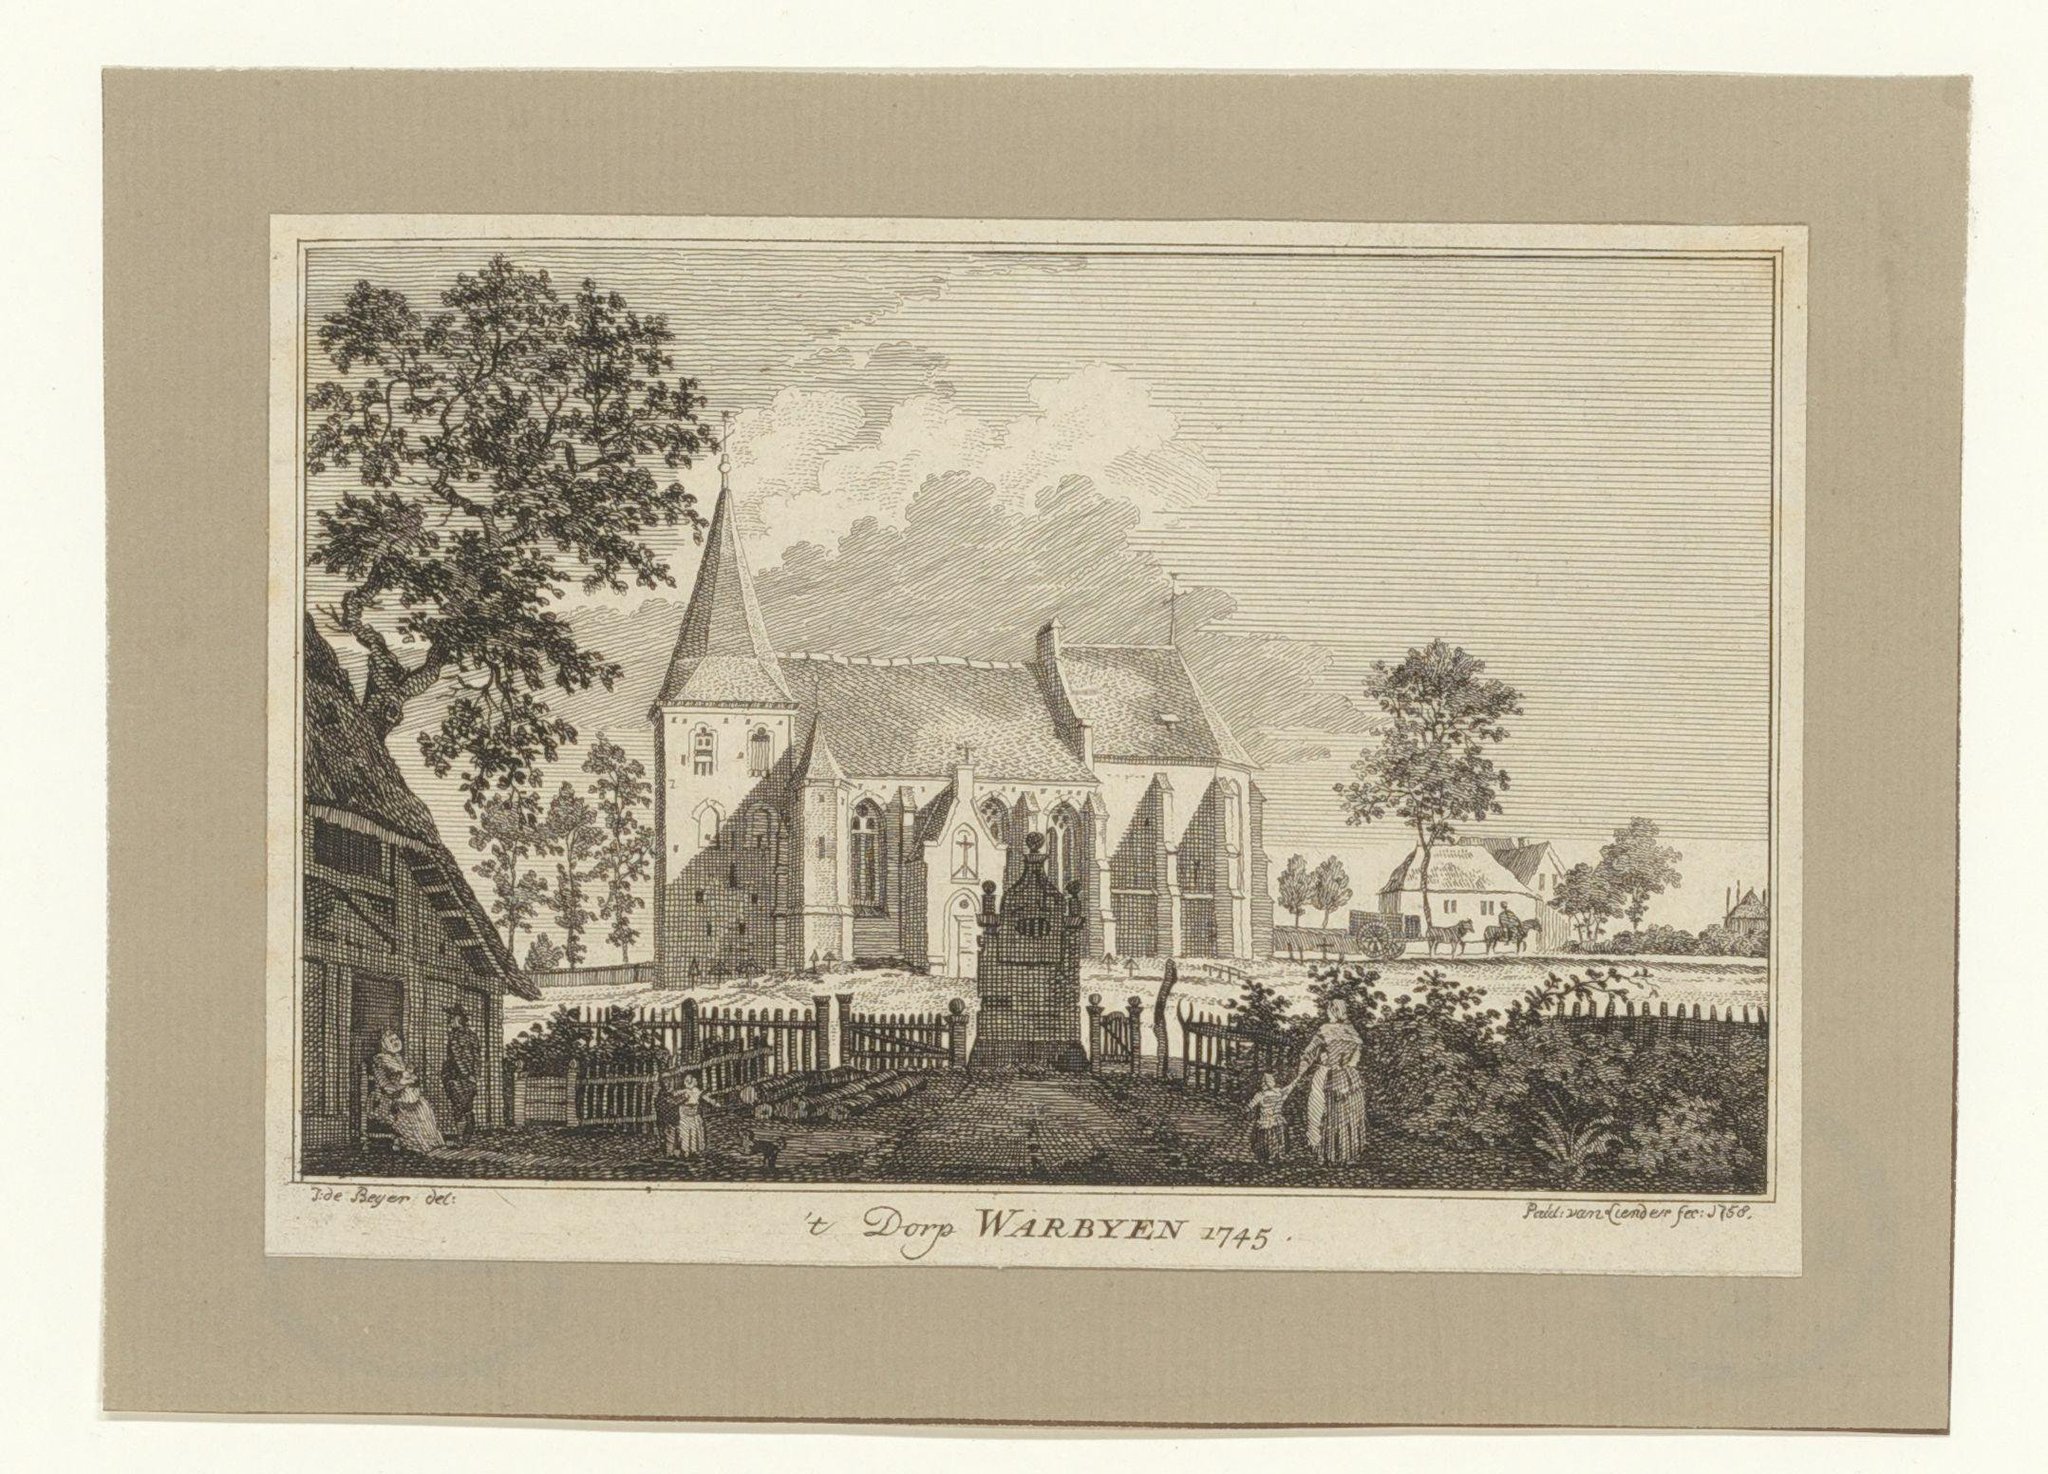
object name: print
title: Gezicht op het dorp Warbyen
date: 1758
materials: paper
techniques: etching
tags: village, church (exterior)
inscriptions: collector's mark: Lugt 1641, collector's mark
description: Gezicht op de kerk in het dorp Warbyen. Onderwerpsrubrieken binnen de Atlas Zeden en Gewoonten: Kerk en kerkwezen & Armwezen en liefdadige instellingen; Kerkgebouwen elders. V-Z.